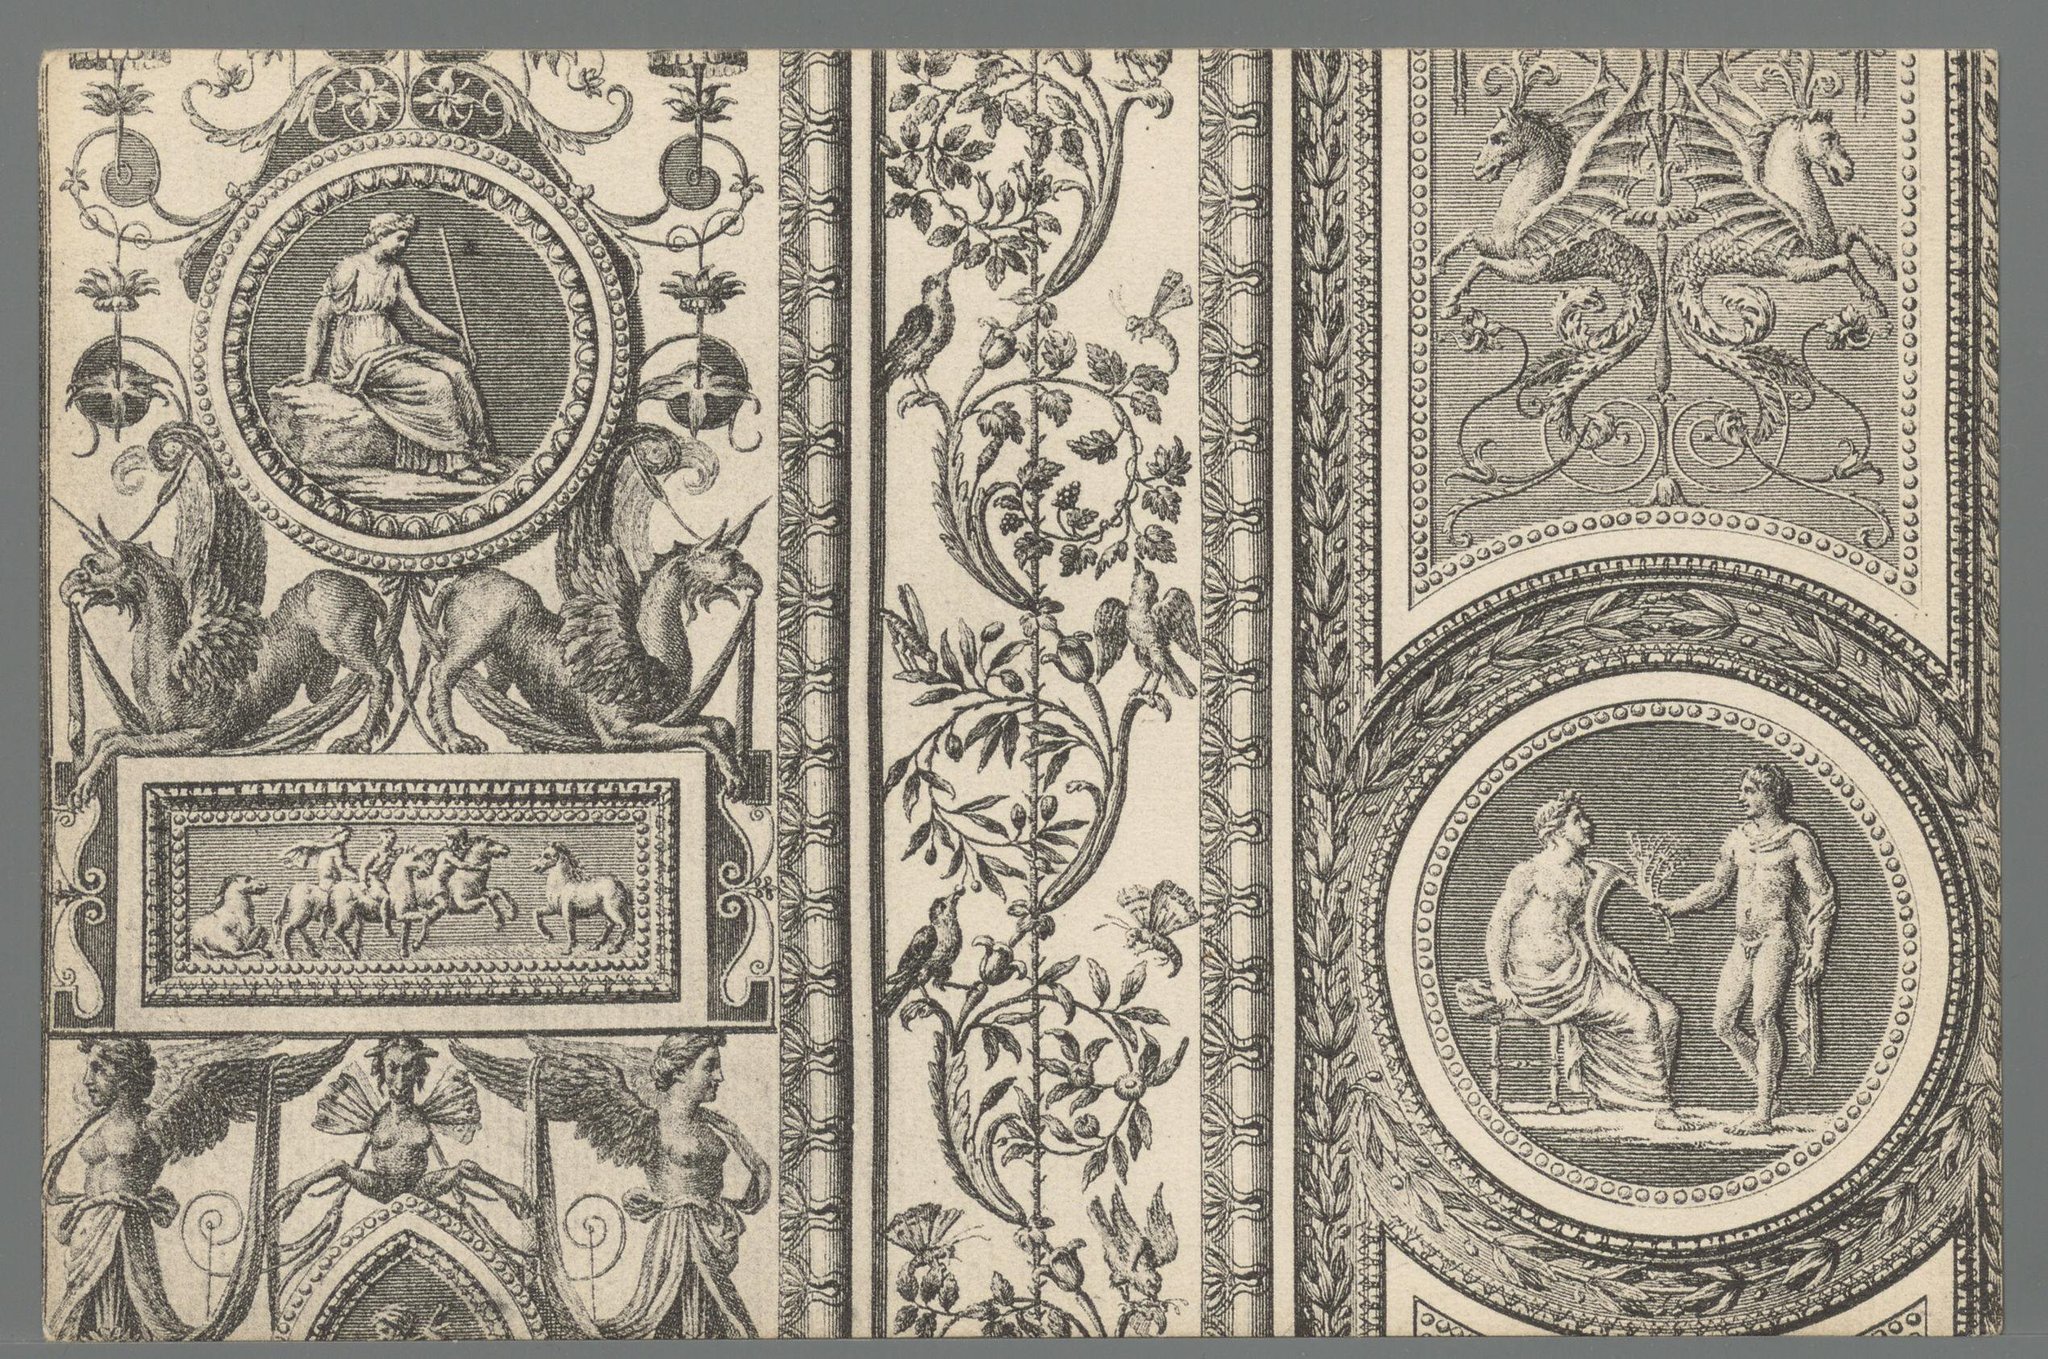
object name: reproduction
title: Roma. Loggie di Raffaello Sanzio nel Vaticano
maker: Anonymous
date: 1906-1920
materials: cardboard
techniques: photograph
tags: palace - aa - civic architecture: inside, decorations (interior of the house), picture, painting